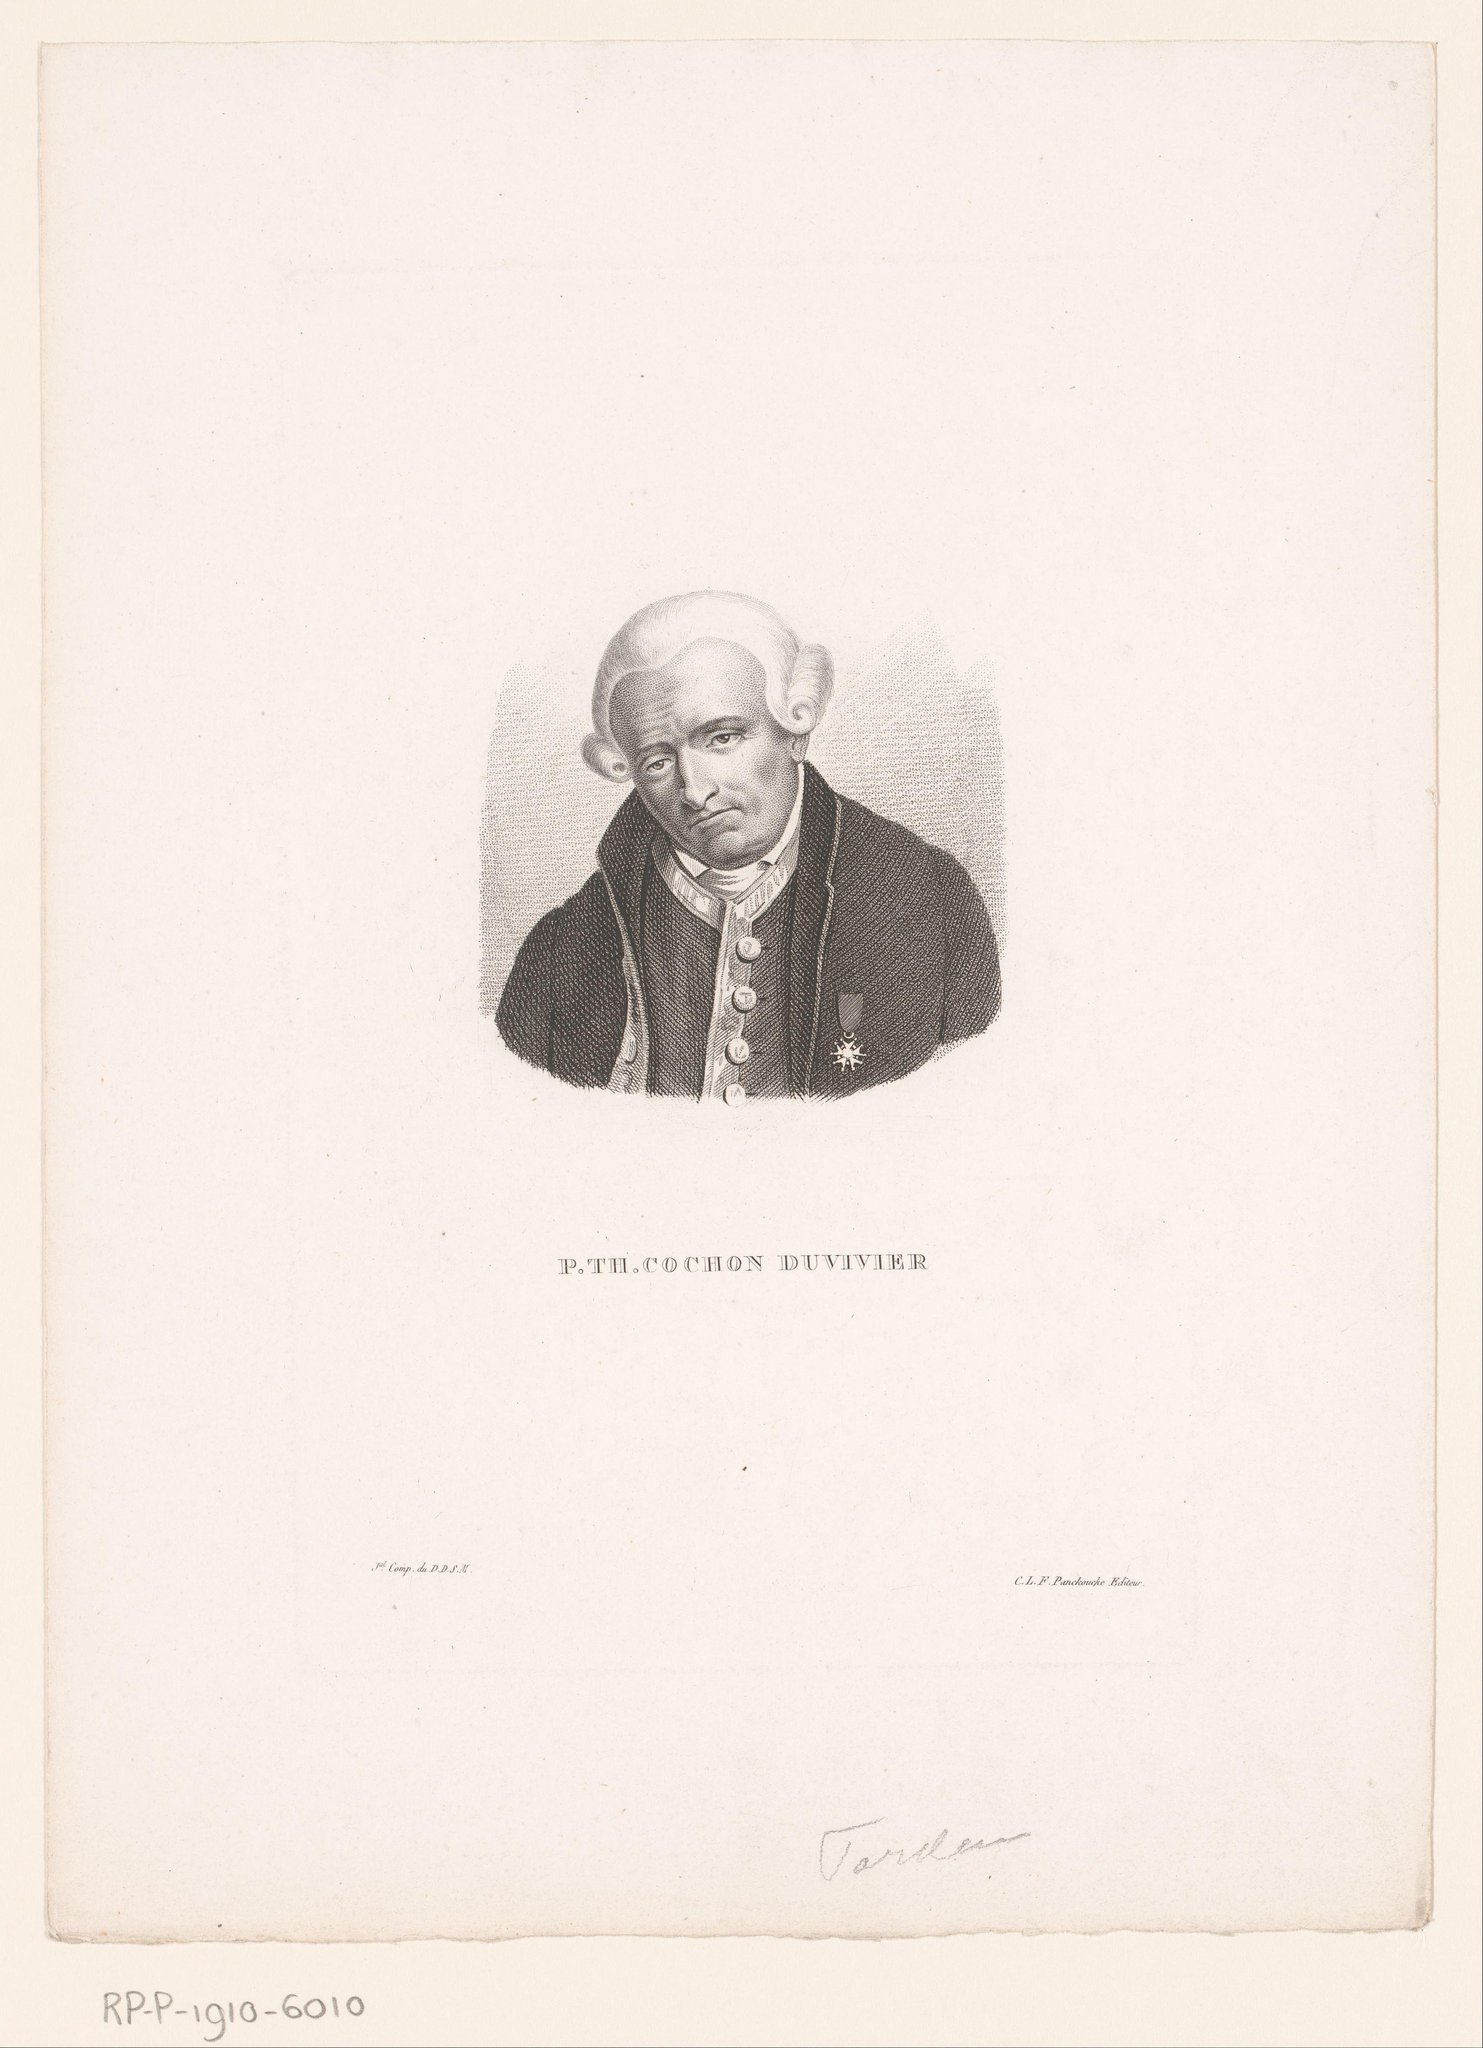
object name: print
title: Portret van Pierre-Jacques-Thomas Cochon-Duvivier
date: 1818-1832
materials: paper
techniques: engraving, etching, roulette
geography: paris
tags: politician, historical persons, physician, doctor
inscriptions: collector's mark: Lugt 2228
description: Prent uit: Journal complémentaire du Dictionnaire des sciences médicales. Parijs: Panckoucke, Charles Louis Fleury, 1818-1832.